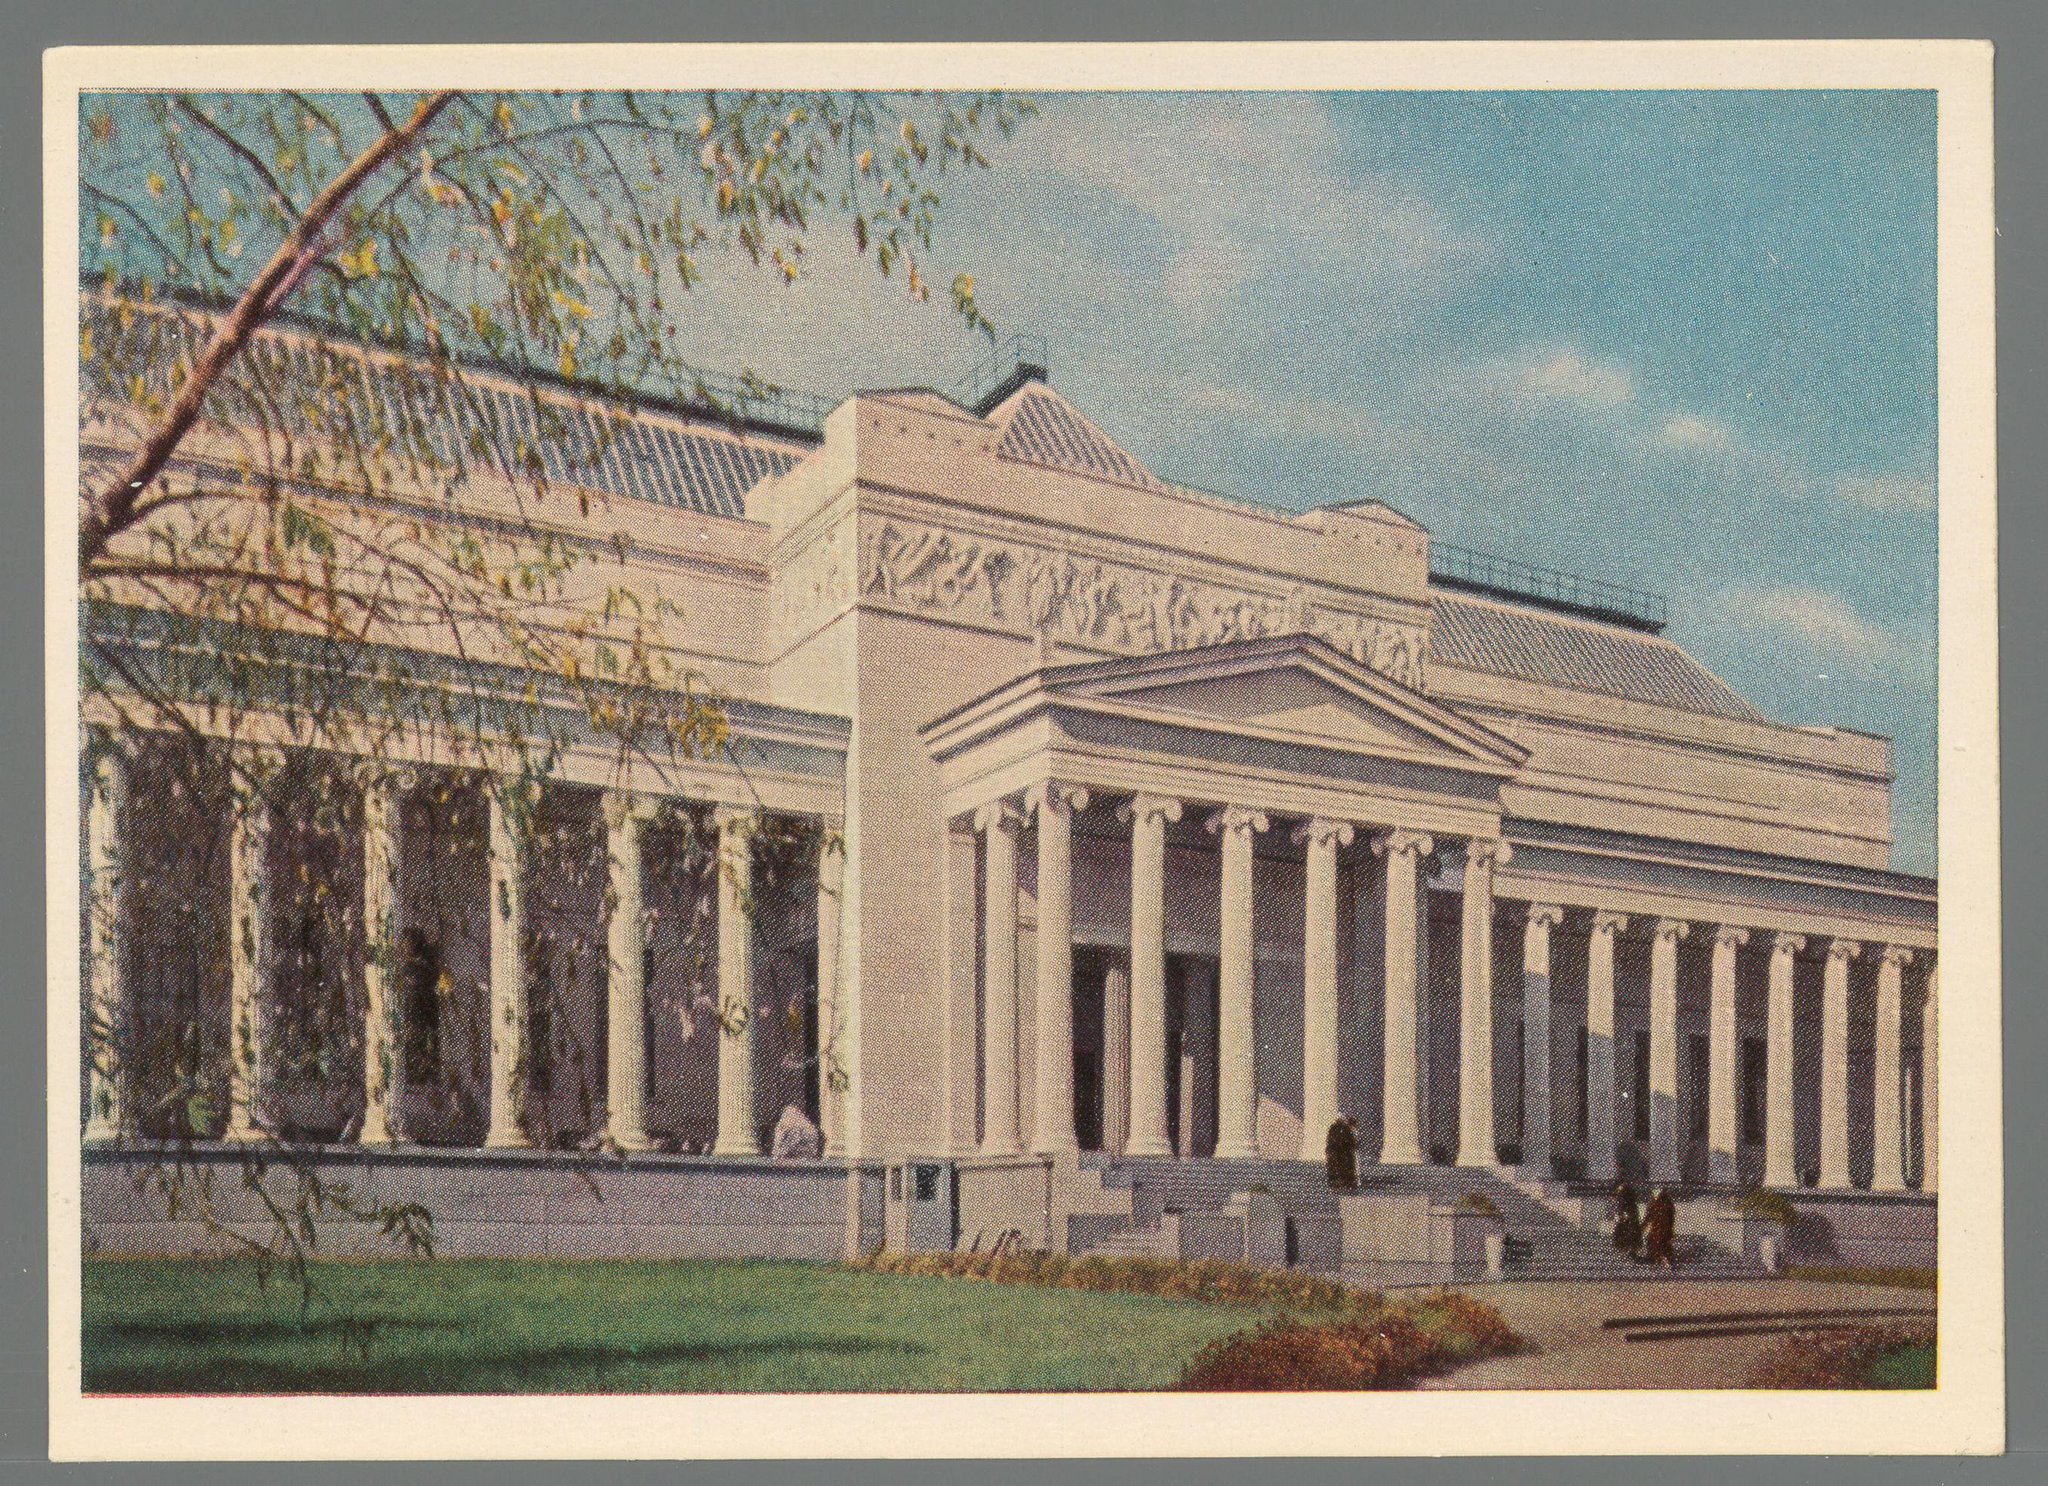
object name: photomechanical print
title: Moscow. The Pushkin State Museum of Fine Arts / Moskau. Staatliches Puschkin-Museum für bildende Kunst / Moscou. Musée des Beaux-Arts Pouchkine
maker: Anonymous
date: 1956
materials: cardboard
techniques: color autotype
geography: moscow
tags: permanent exhibition, museum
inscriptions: date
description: De titel op object staat ook in het Russisch.